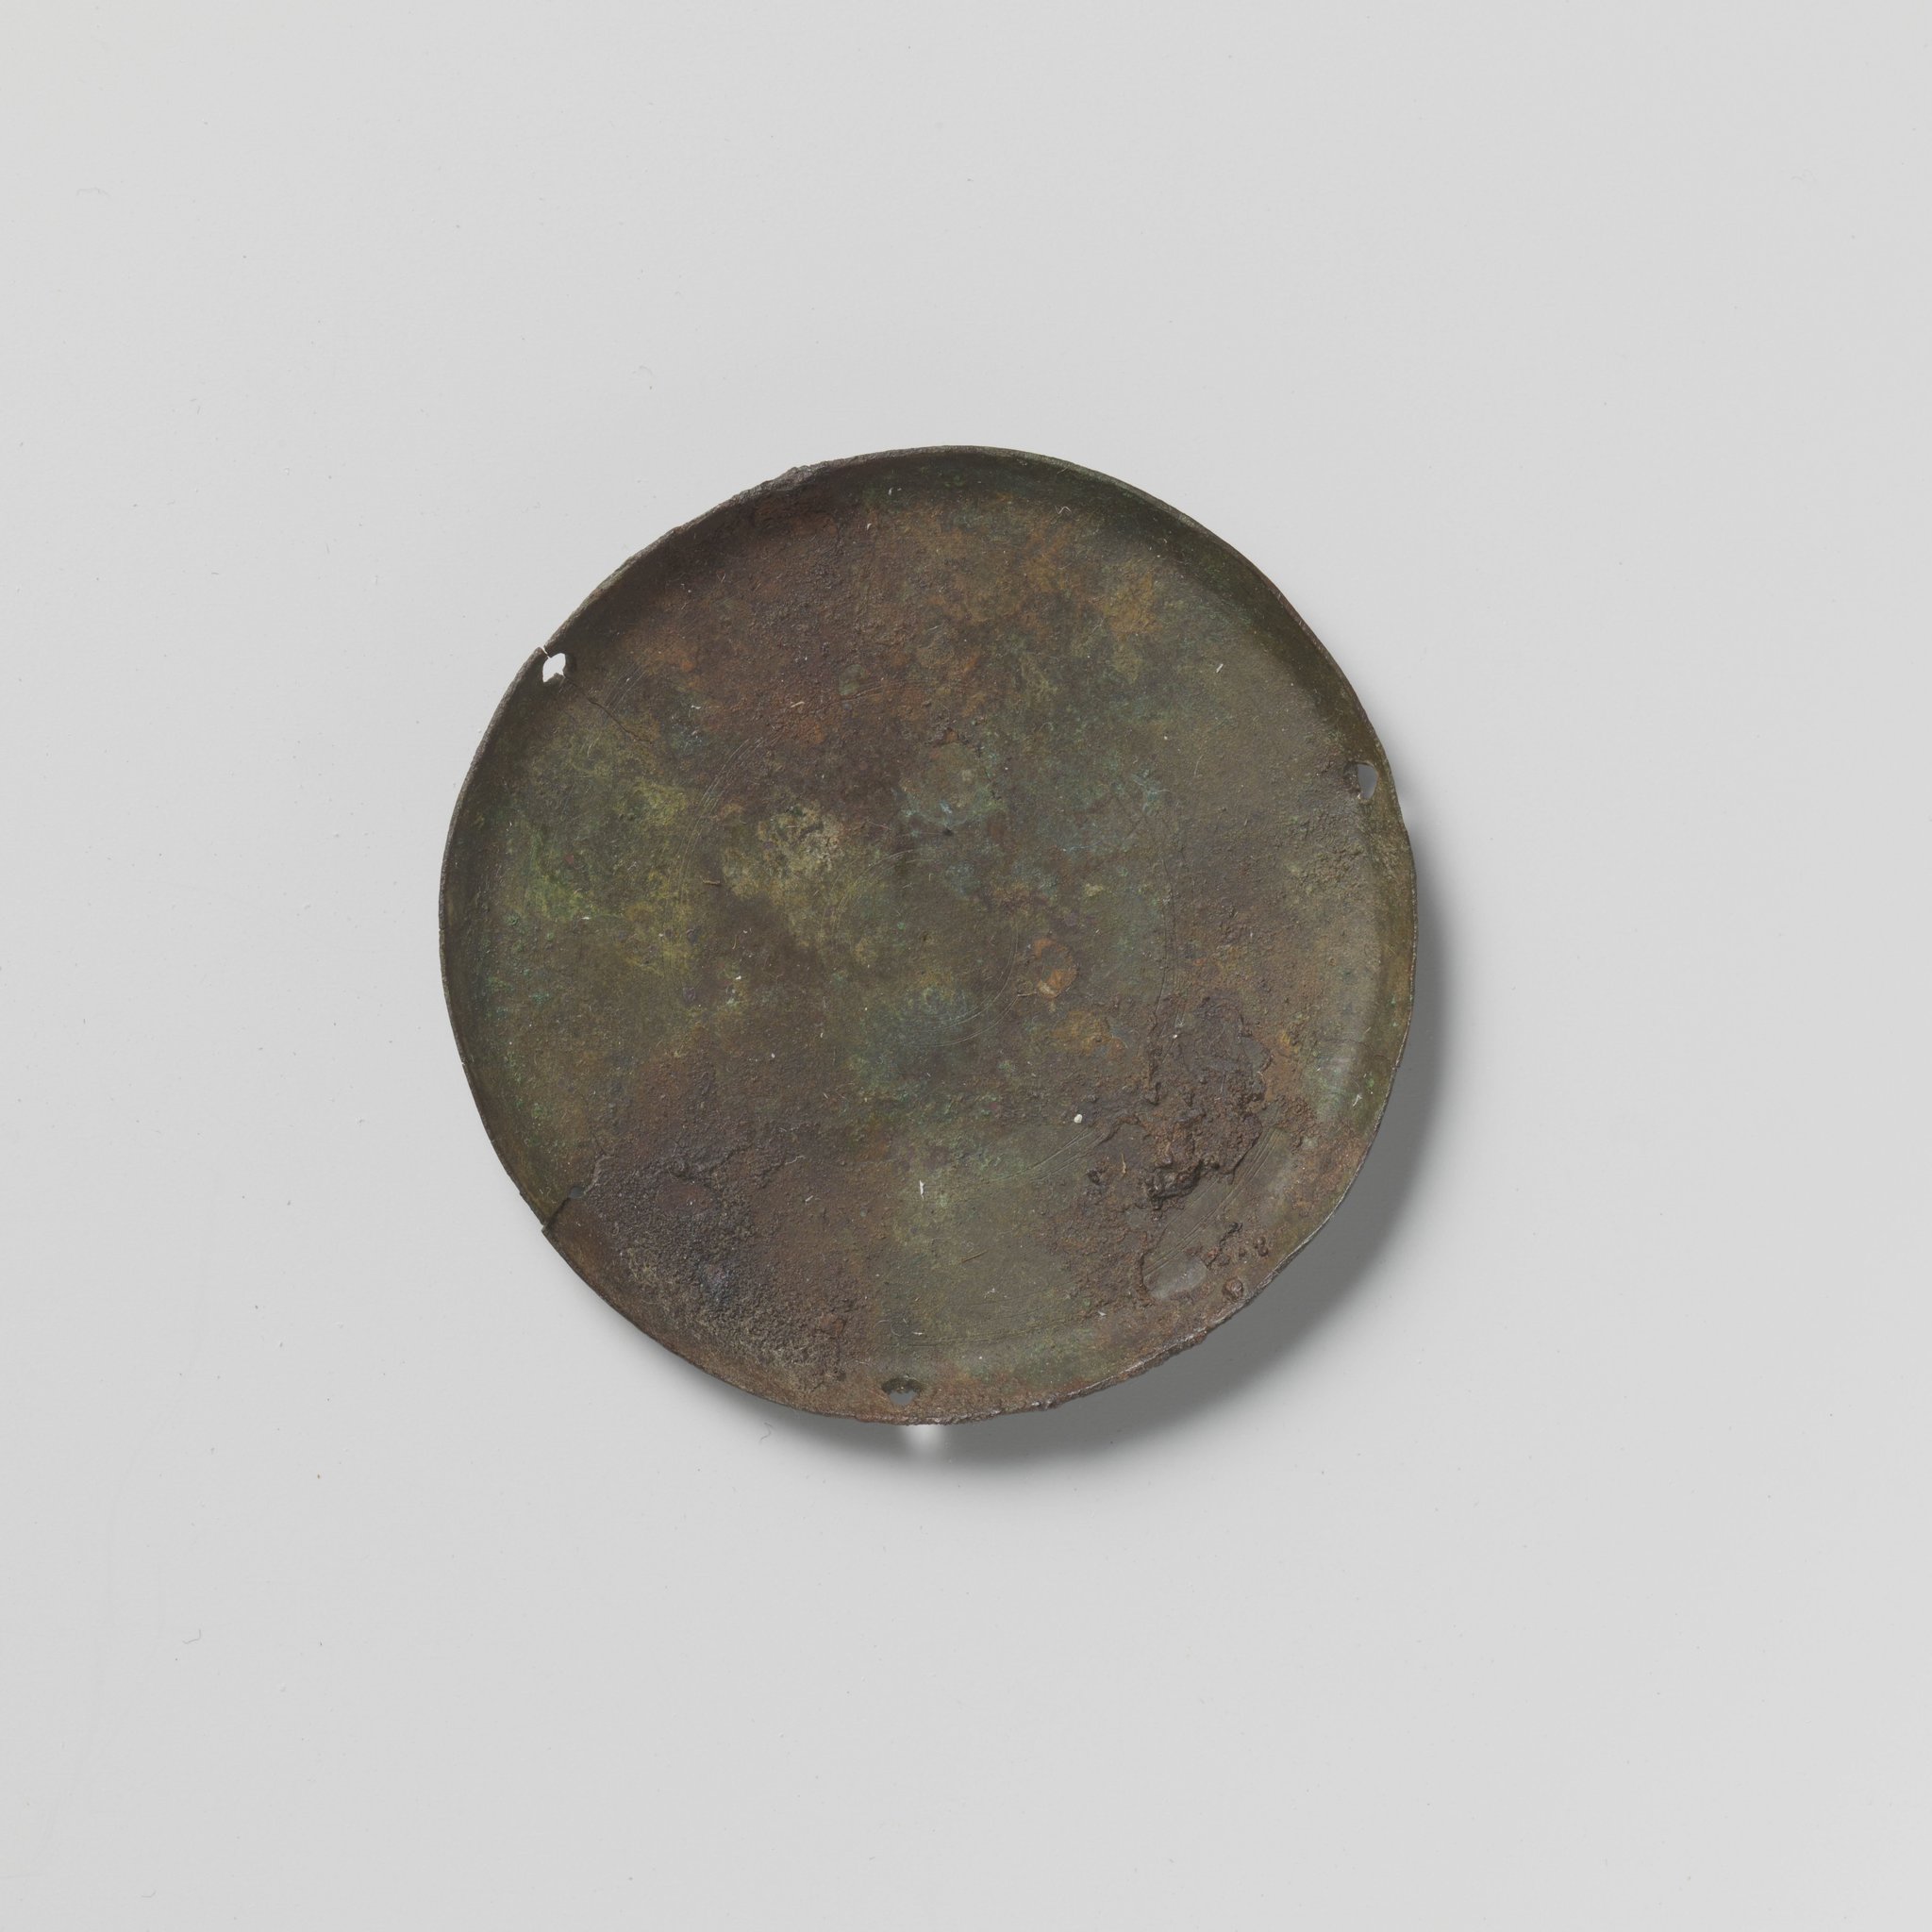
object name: weegschaal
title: Weegschaal van koper, rond en plat met een opstaand randje waarin drie gaatjes zijn aangebracht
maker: Anonymous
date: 1590-1596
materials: copper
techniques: striking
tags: willem barendsz., amsterdam, jacob van heemskerck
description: Weegschaaltje van koper, rond en plat met een opstaand randje waarin drie gaatjes zijn aangebracht. De weegschaal heeft waarschijnlijk gediend voor het afwegen van geneesmiddelen. Volgens De Veer is een barbier of chirurgijn meegeweest met de tocht.